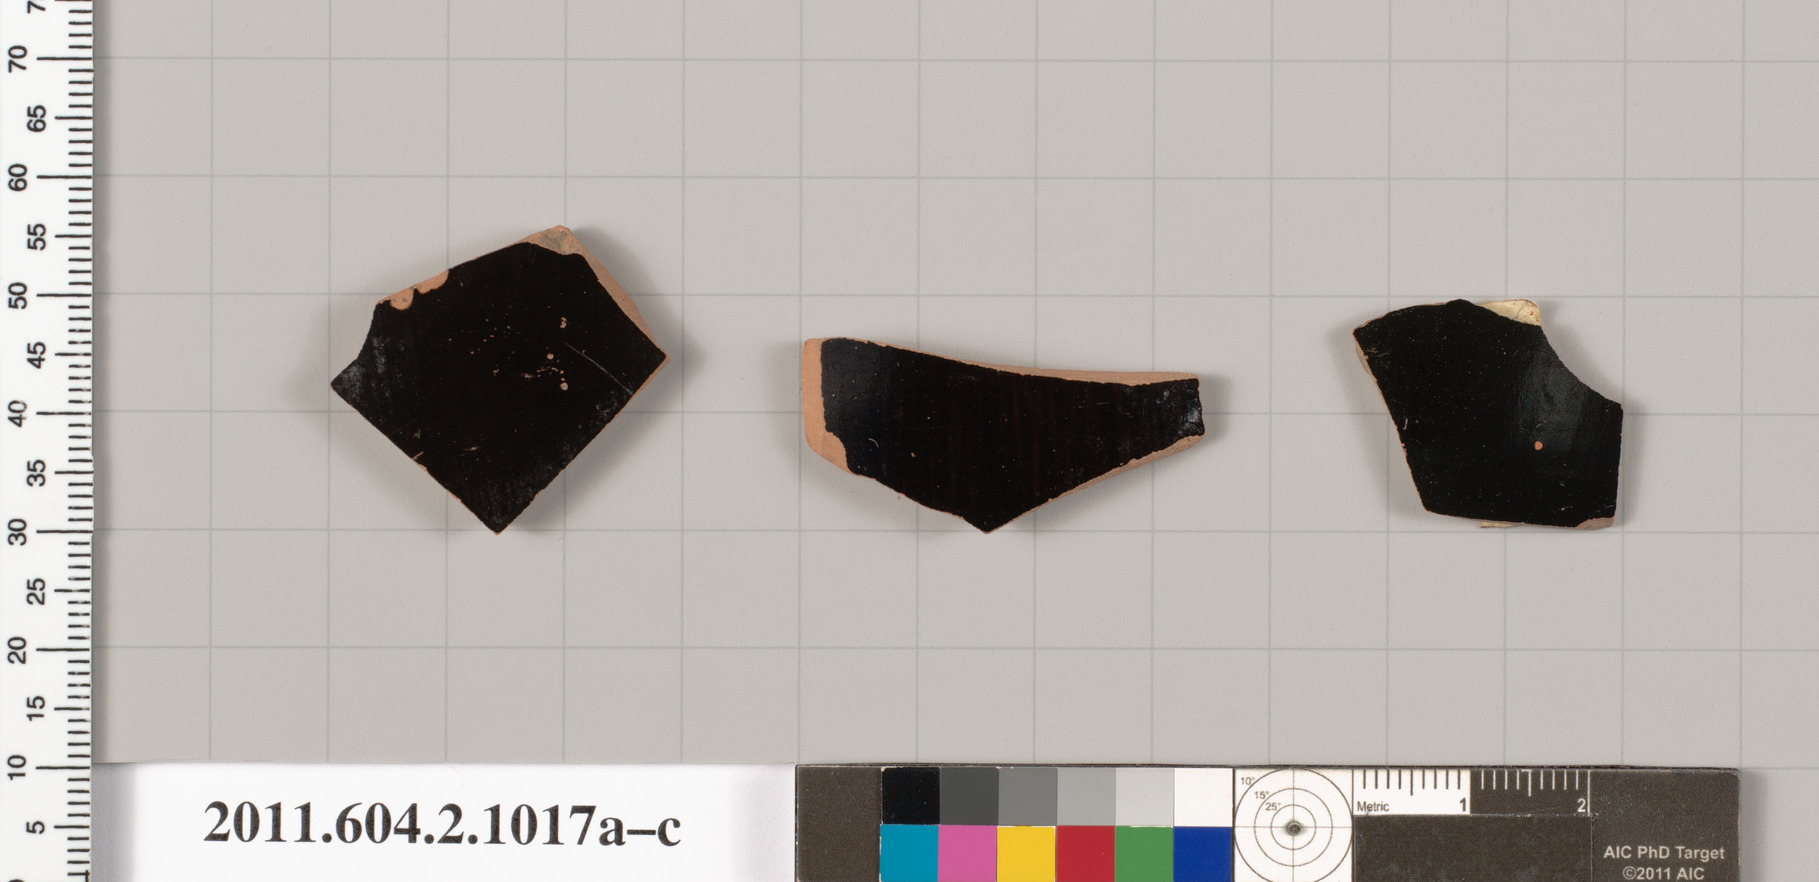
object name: oinochoe fragment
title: Terracotta fragments of oinochoai (jugs)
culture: greek, attic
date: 475-425 BCE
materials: terracotta